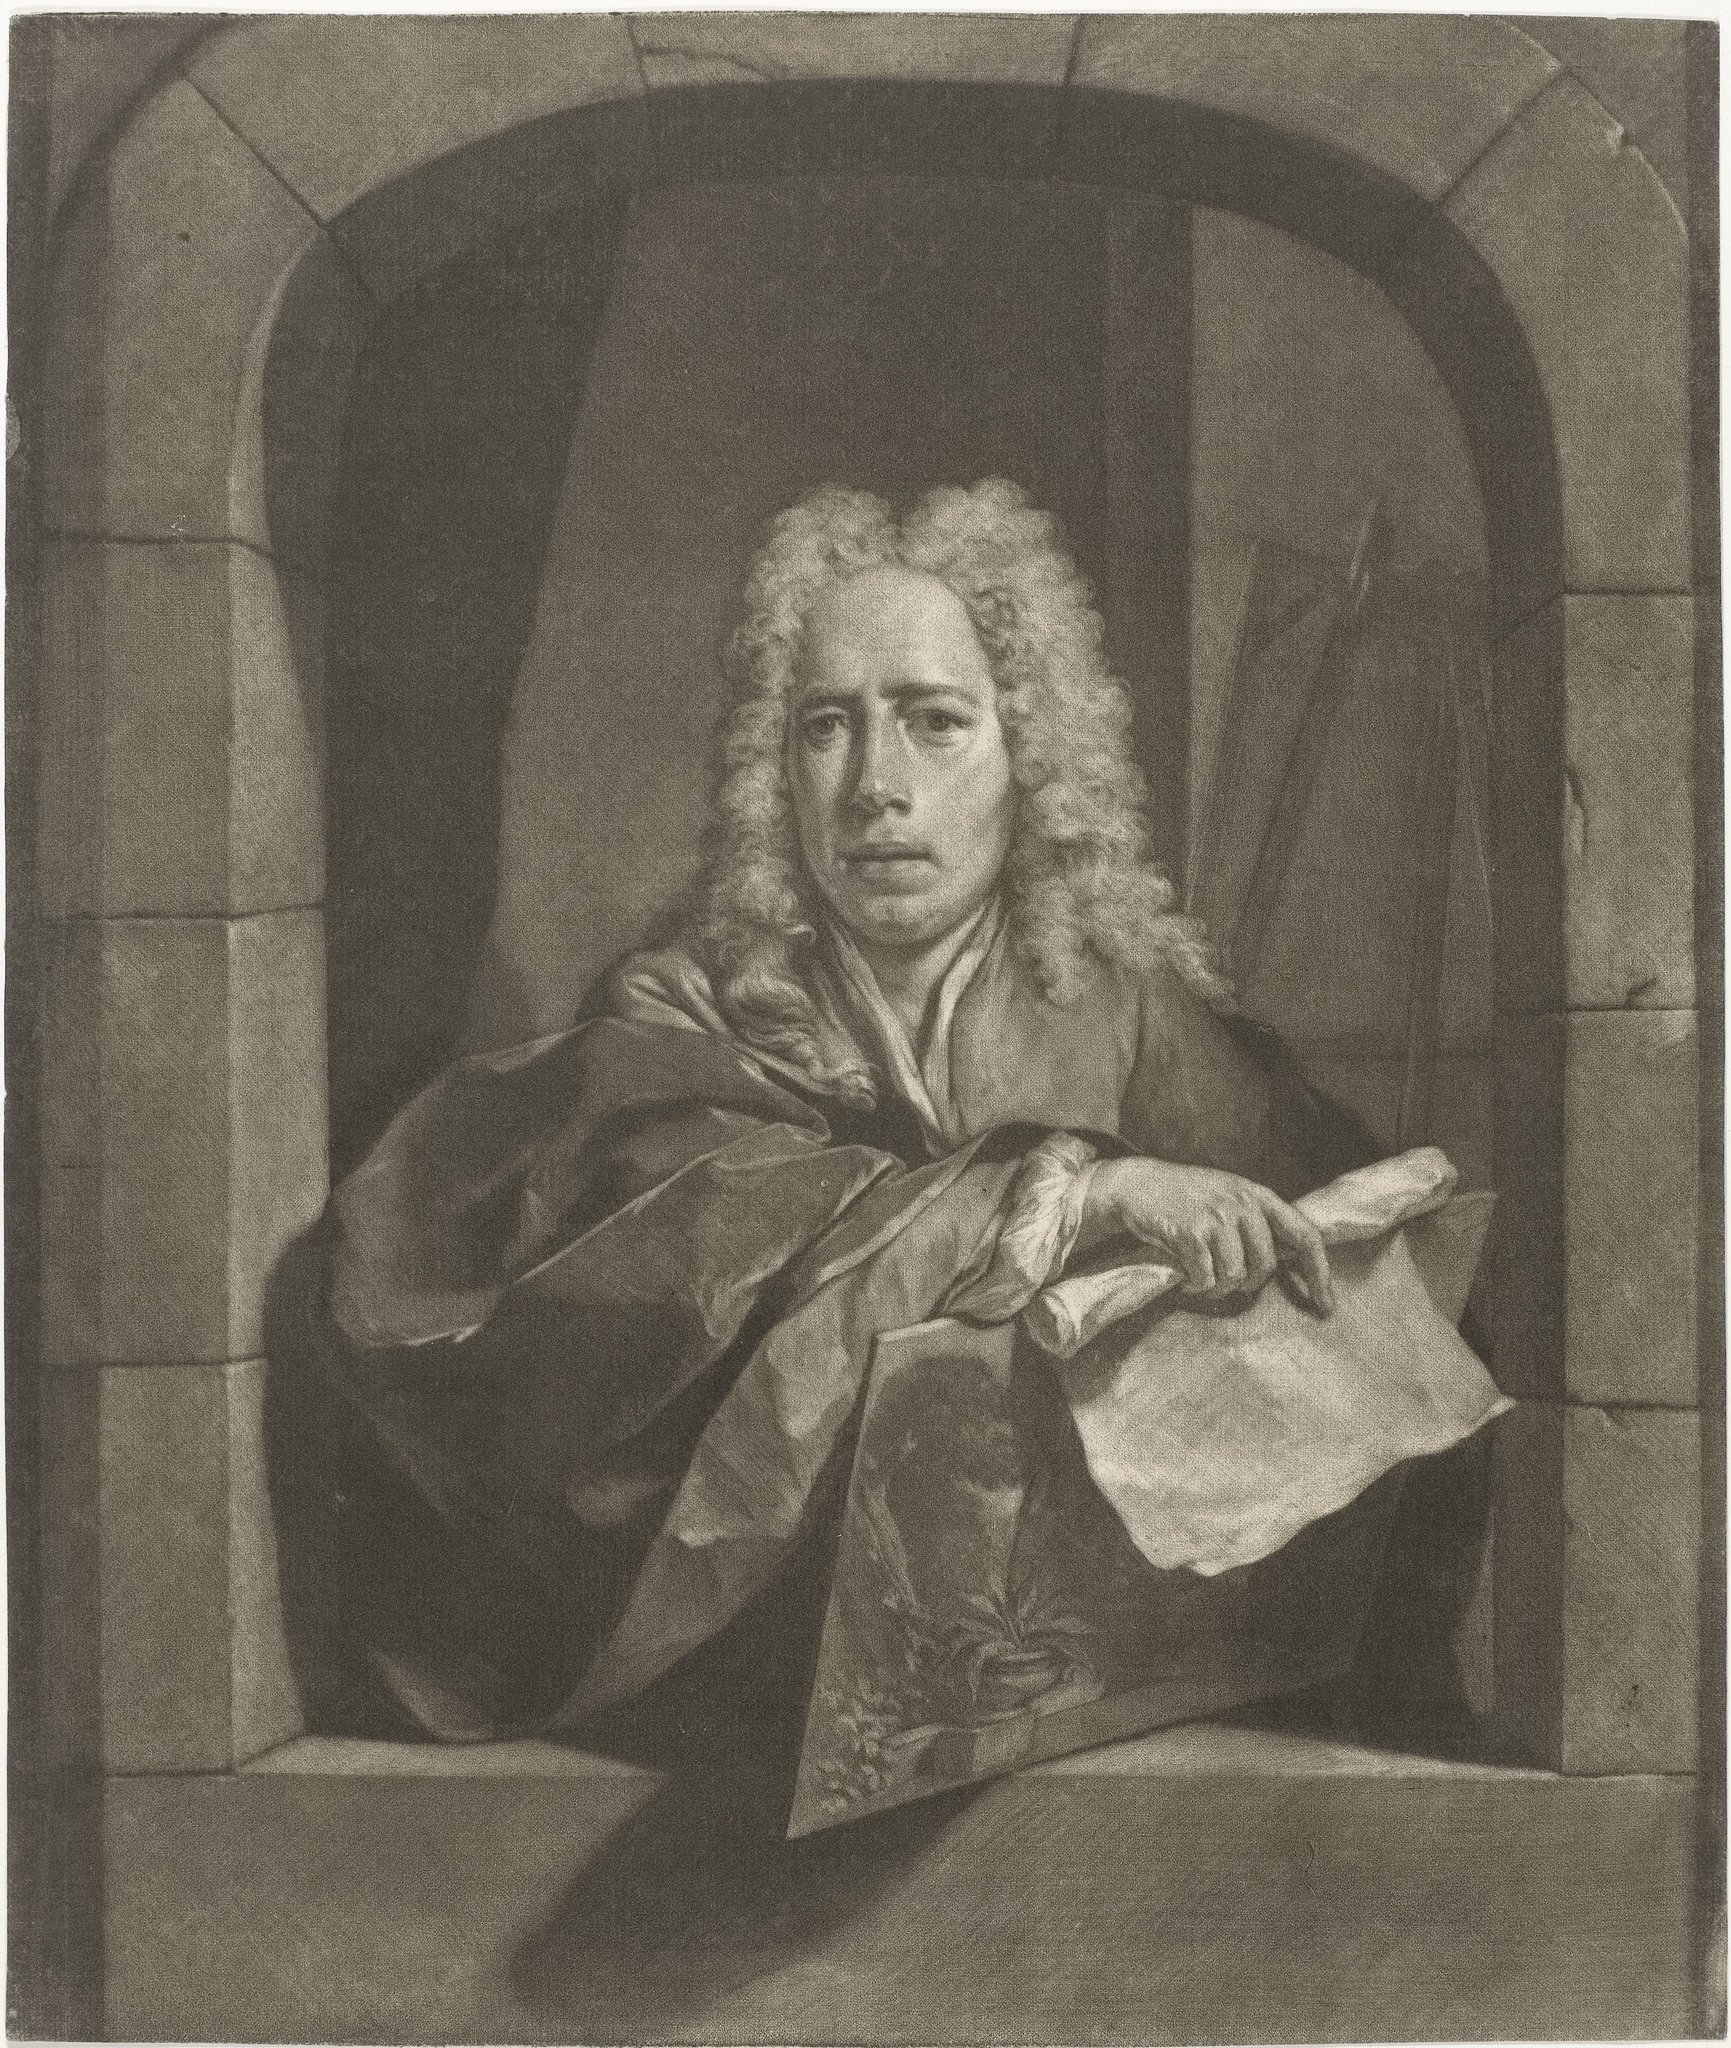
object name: print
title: Portret van Carel Borchaert Voet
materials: paper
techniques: mezzotint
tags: dordrecht, draughtsman, carel borchaert voet, drawing, portrait, self-portrait of painter, easel, picture, painting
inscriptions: collector's mark: Lugt 2228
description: Karel Borchaert Voet (1670-1743) was stillevenschilder. Hij behoort tot de groep 18de-eeuwse schilders van botanische aquarellen en werkte zowel in Nederland als in Engeland voor Willem Bentinck. Ook maakte hij insectentekeningen voor William III.